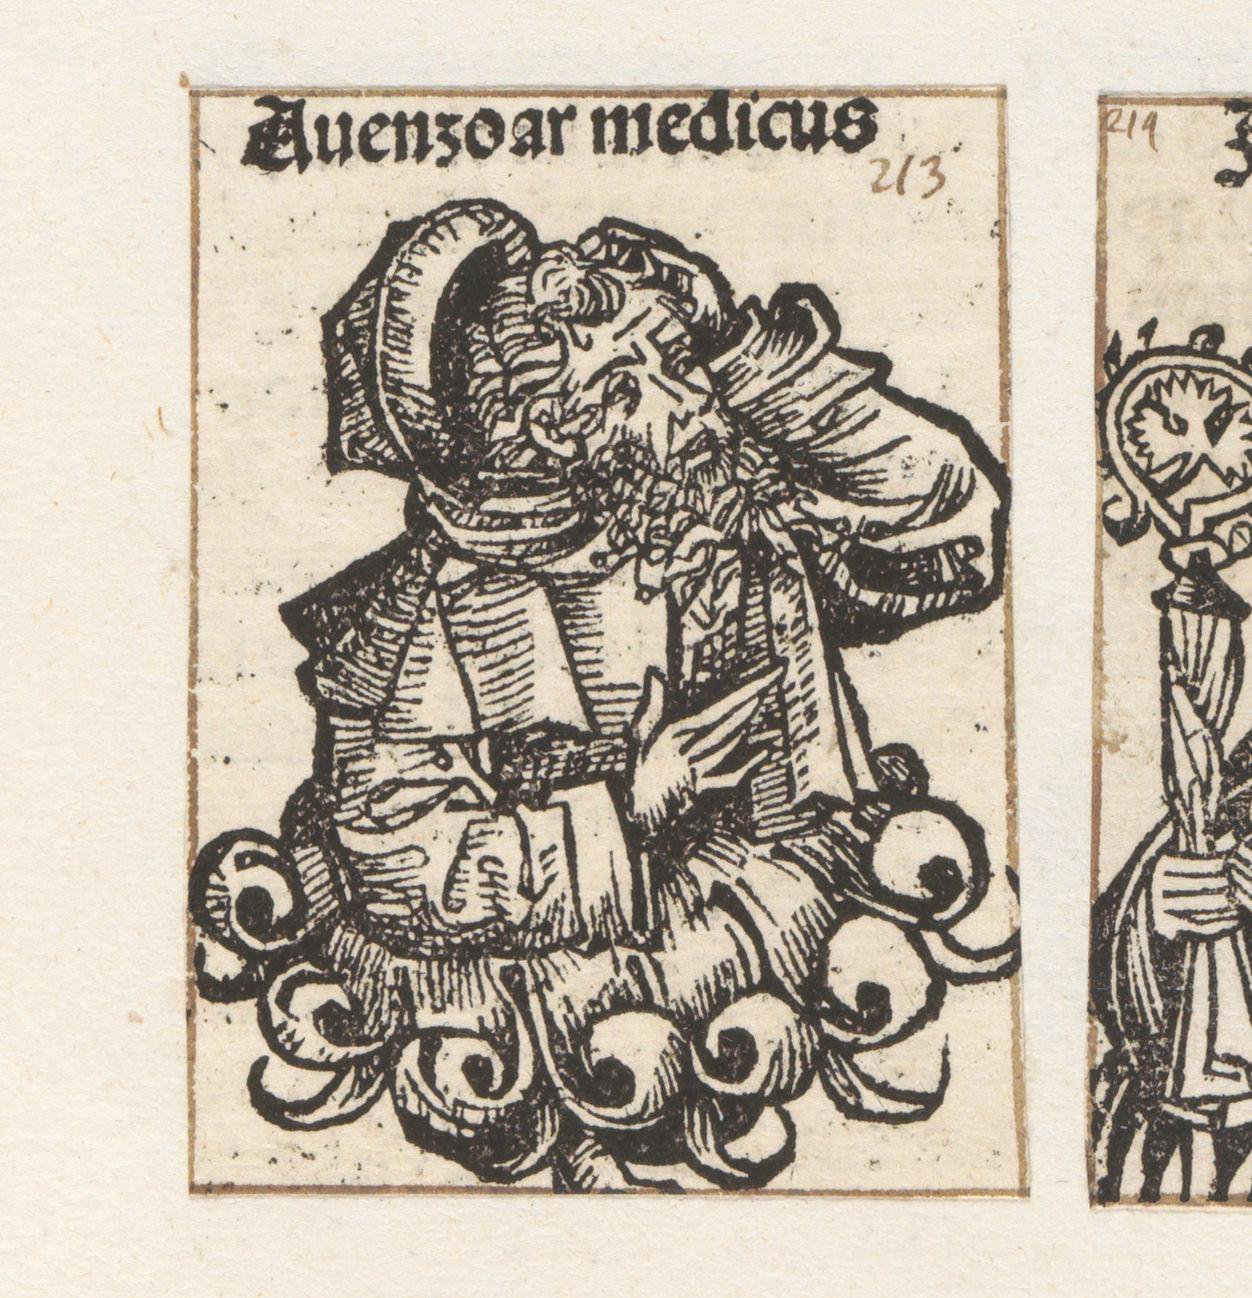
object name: album leaf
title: Avenzoar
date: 1493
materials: paper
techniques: letterpress printing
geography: nuremberg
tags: arts, avenzoar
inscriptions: inscription: ‘213’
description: Een bloemkelk met een bebaarde man. Zijn muts valt af en hij heeft zijn hand bij zijn hoofd. De tekst identificeert hem als Avenzoar (Ibn Zuhr), een Arabische psycholoog en chirurg. De prent maakt deel uit van een album.